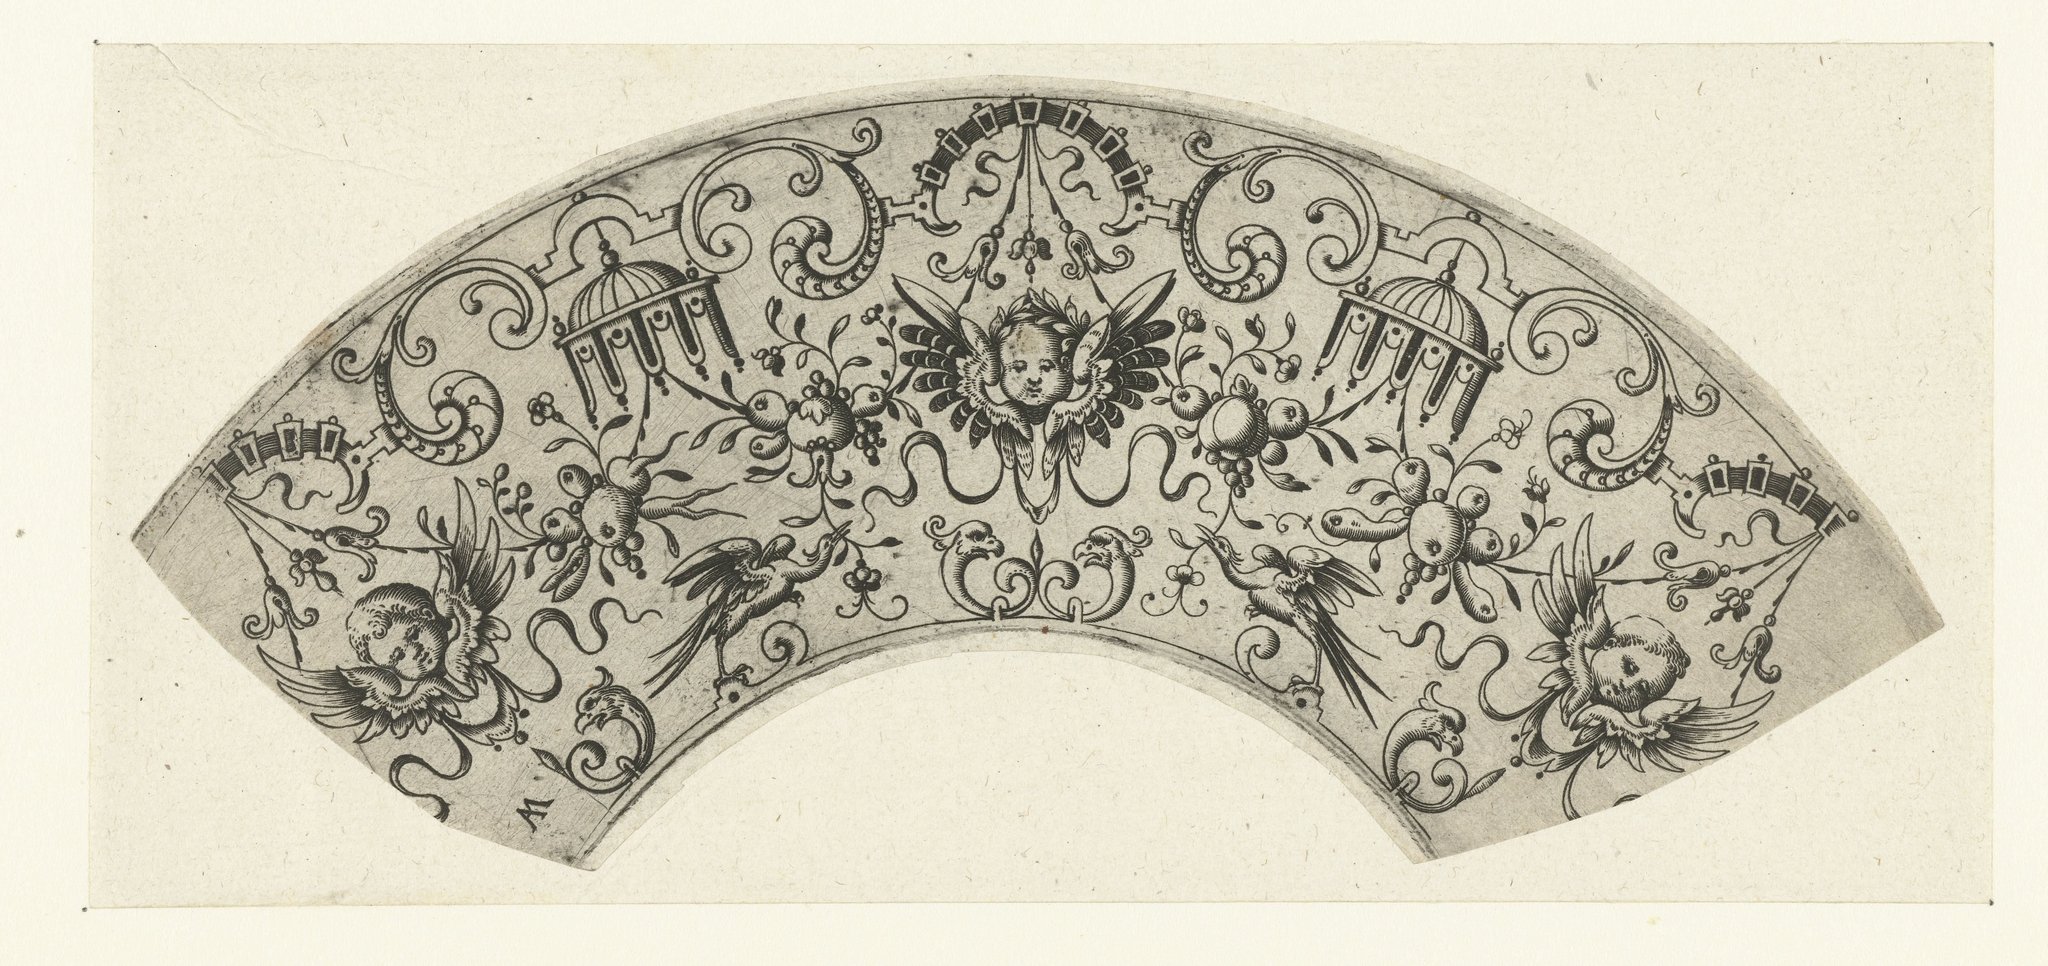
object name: ornament print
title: Rand met cherubijnen en baldakijnen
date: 1615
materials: paper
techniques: engraving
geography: groningen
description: Onderdeel van decoratie voor de rand van een bord. Blad 6 uit een serie van 6.